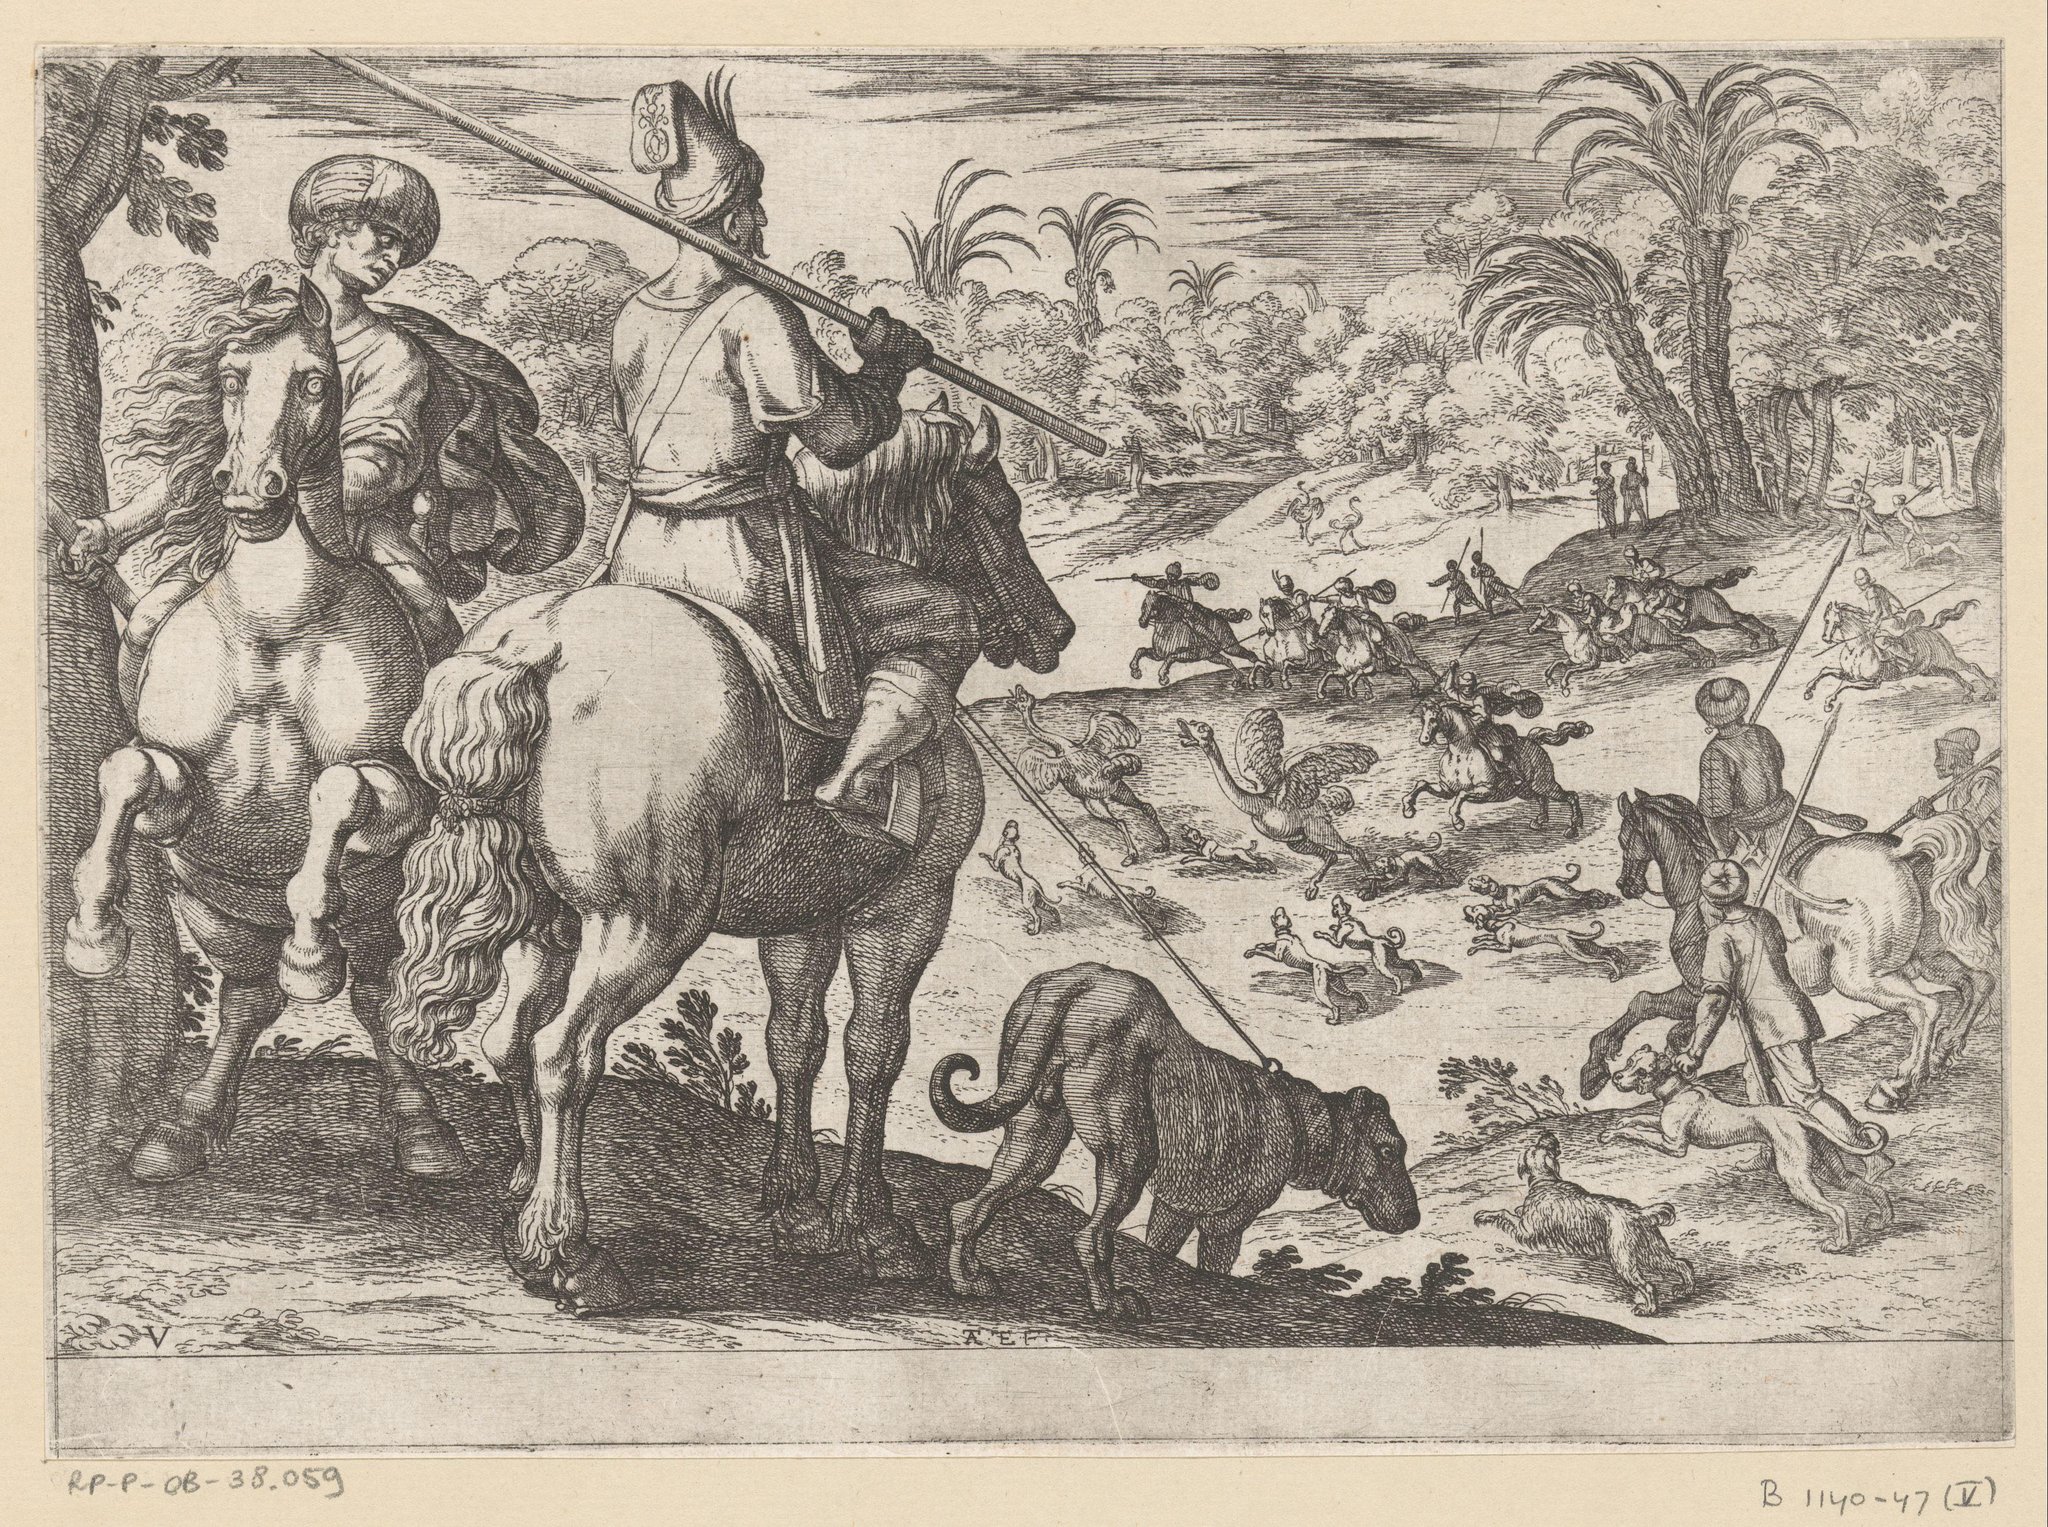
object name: print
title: Jachtscènes (deel 6)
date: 1609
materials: paper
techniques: etching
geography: vatican city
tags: walker and runner birds: ostrich, hunter, hunters hunting (n.b.: in 1988-1990 this notation denoted the concept of 43c11421 'hunters resting during the hunt'), bird hunting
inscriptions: collector's mark: Lugt 240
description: Deze prent maakt deel uit van een reeks van negen prenten met jachtscènes (+ opdracht).